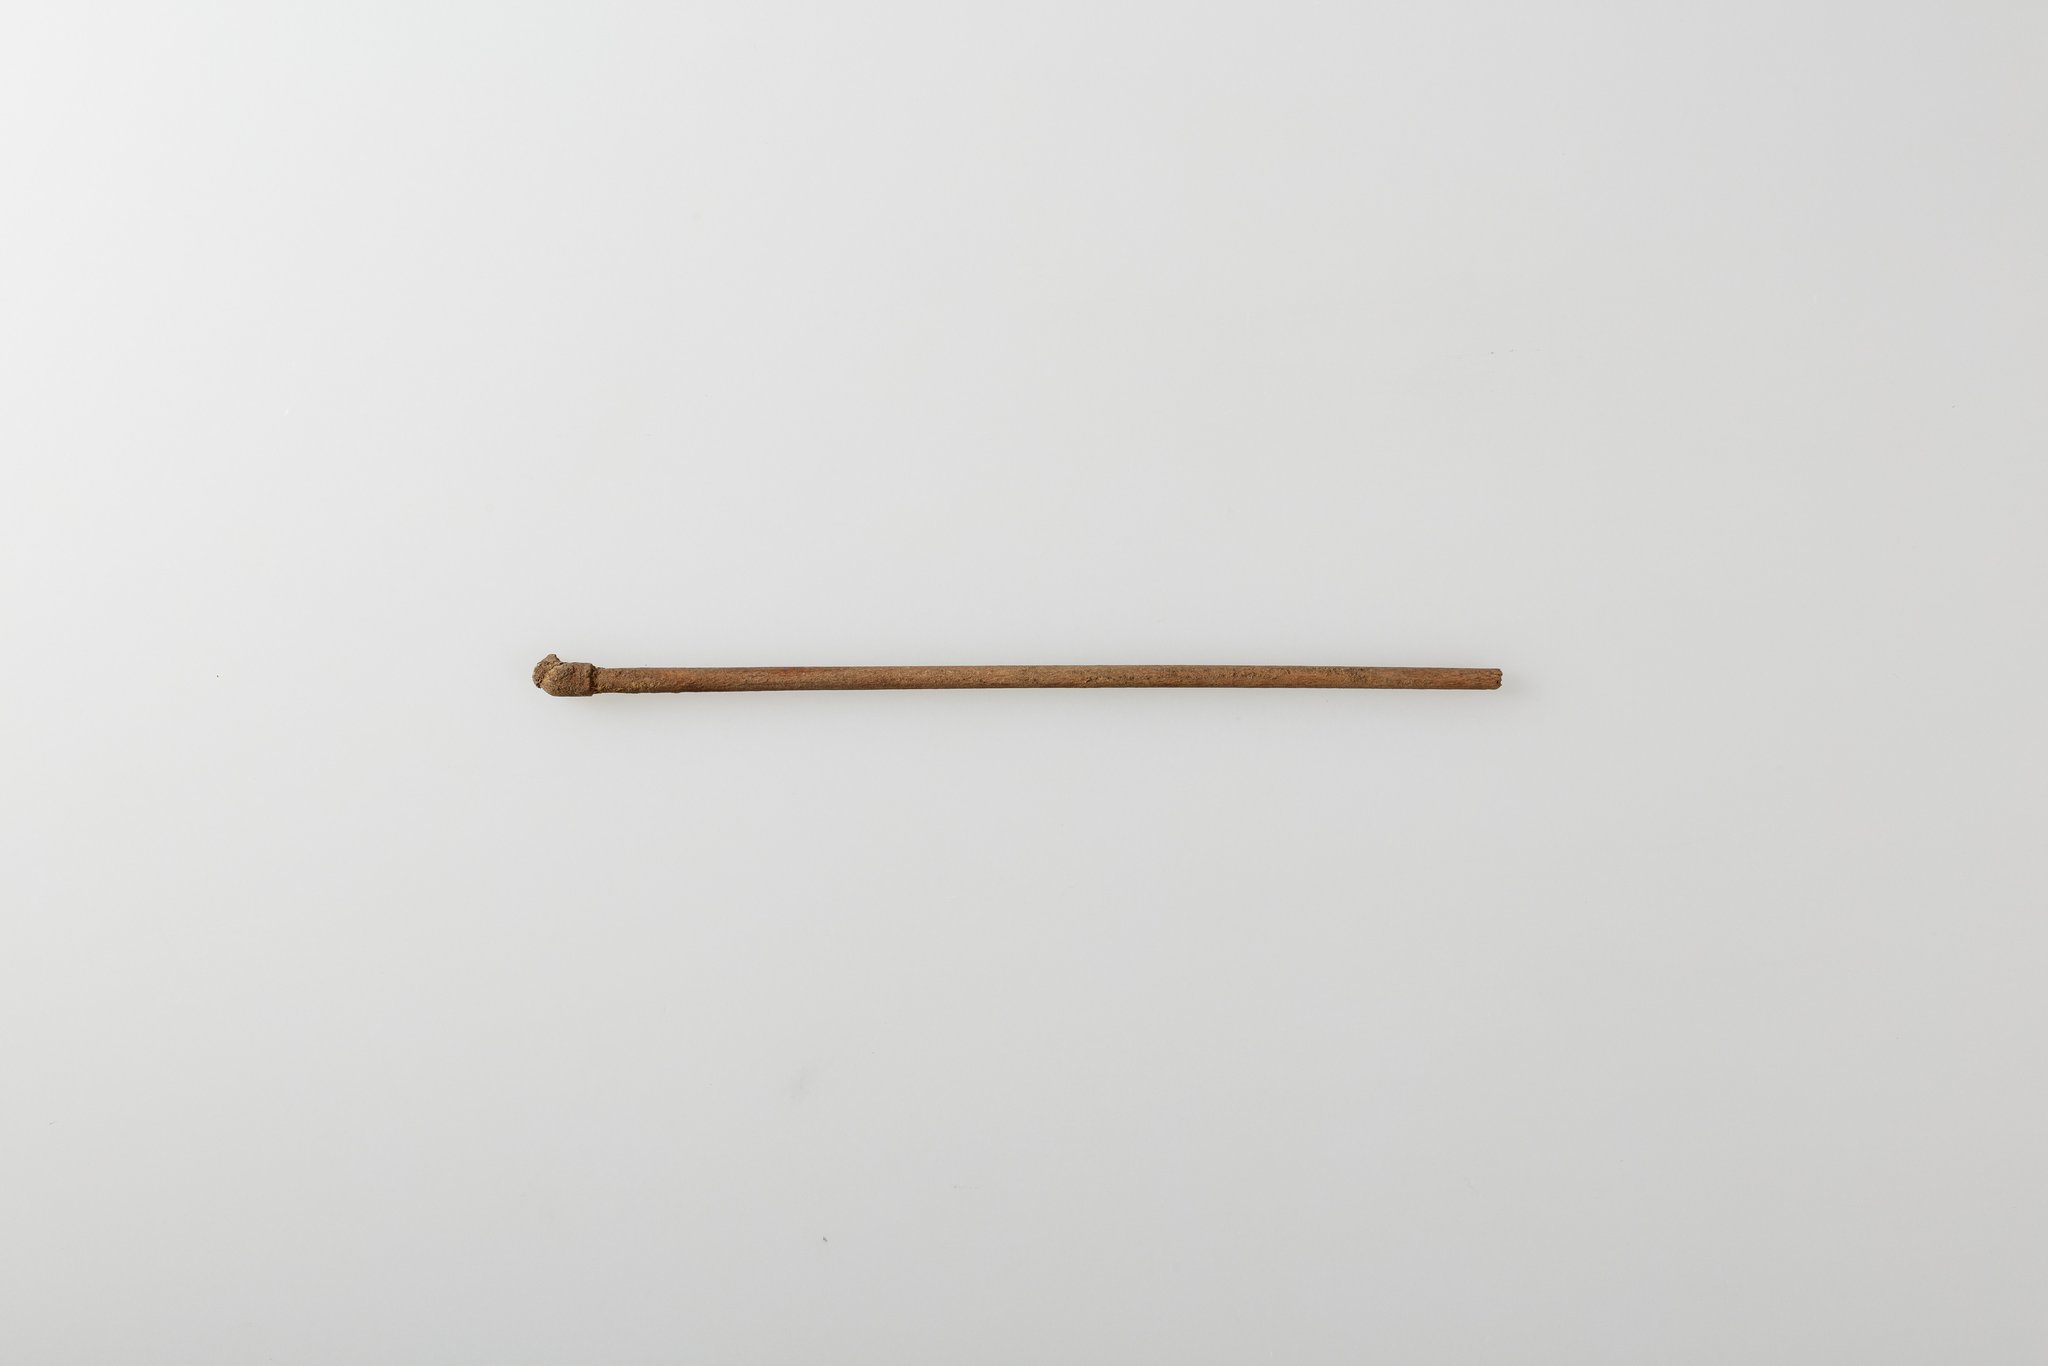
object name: embalming tool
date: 945-525 BCE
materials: wood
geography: egypt